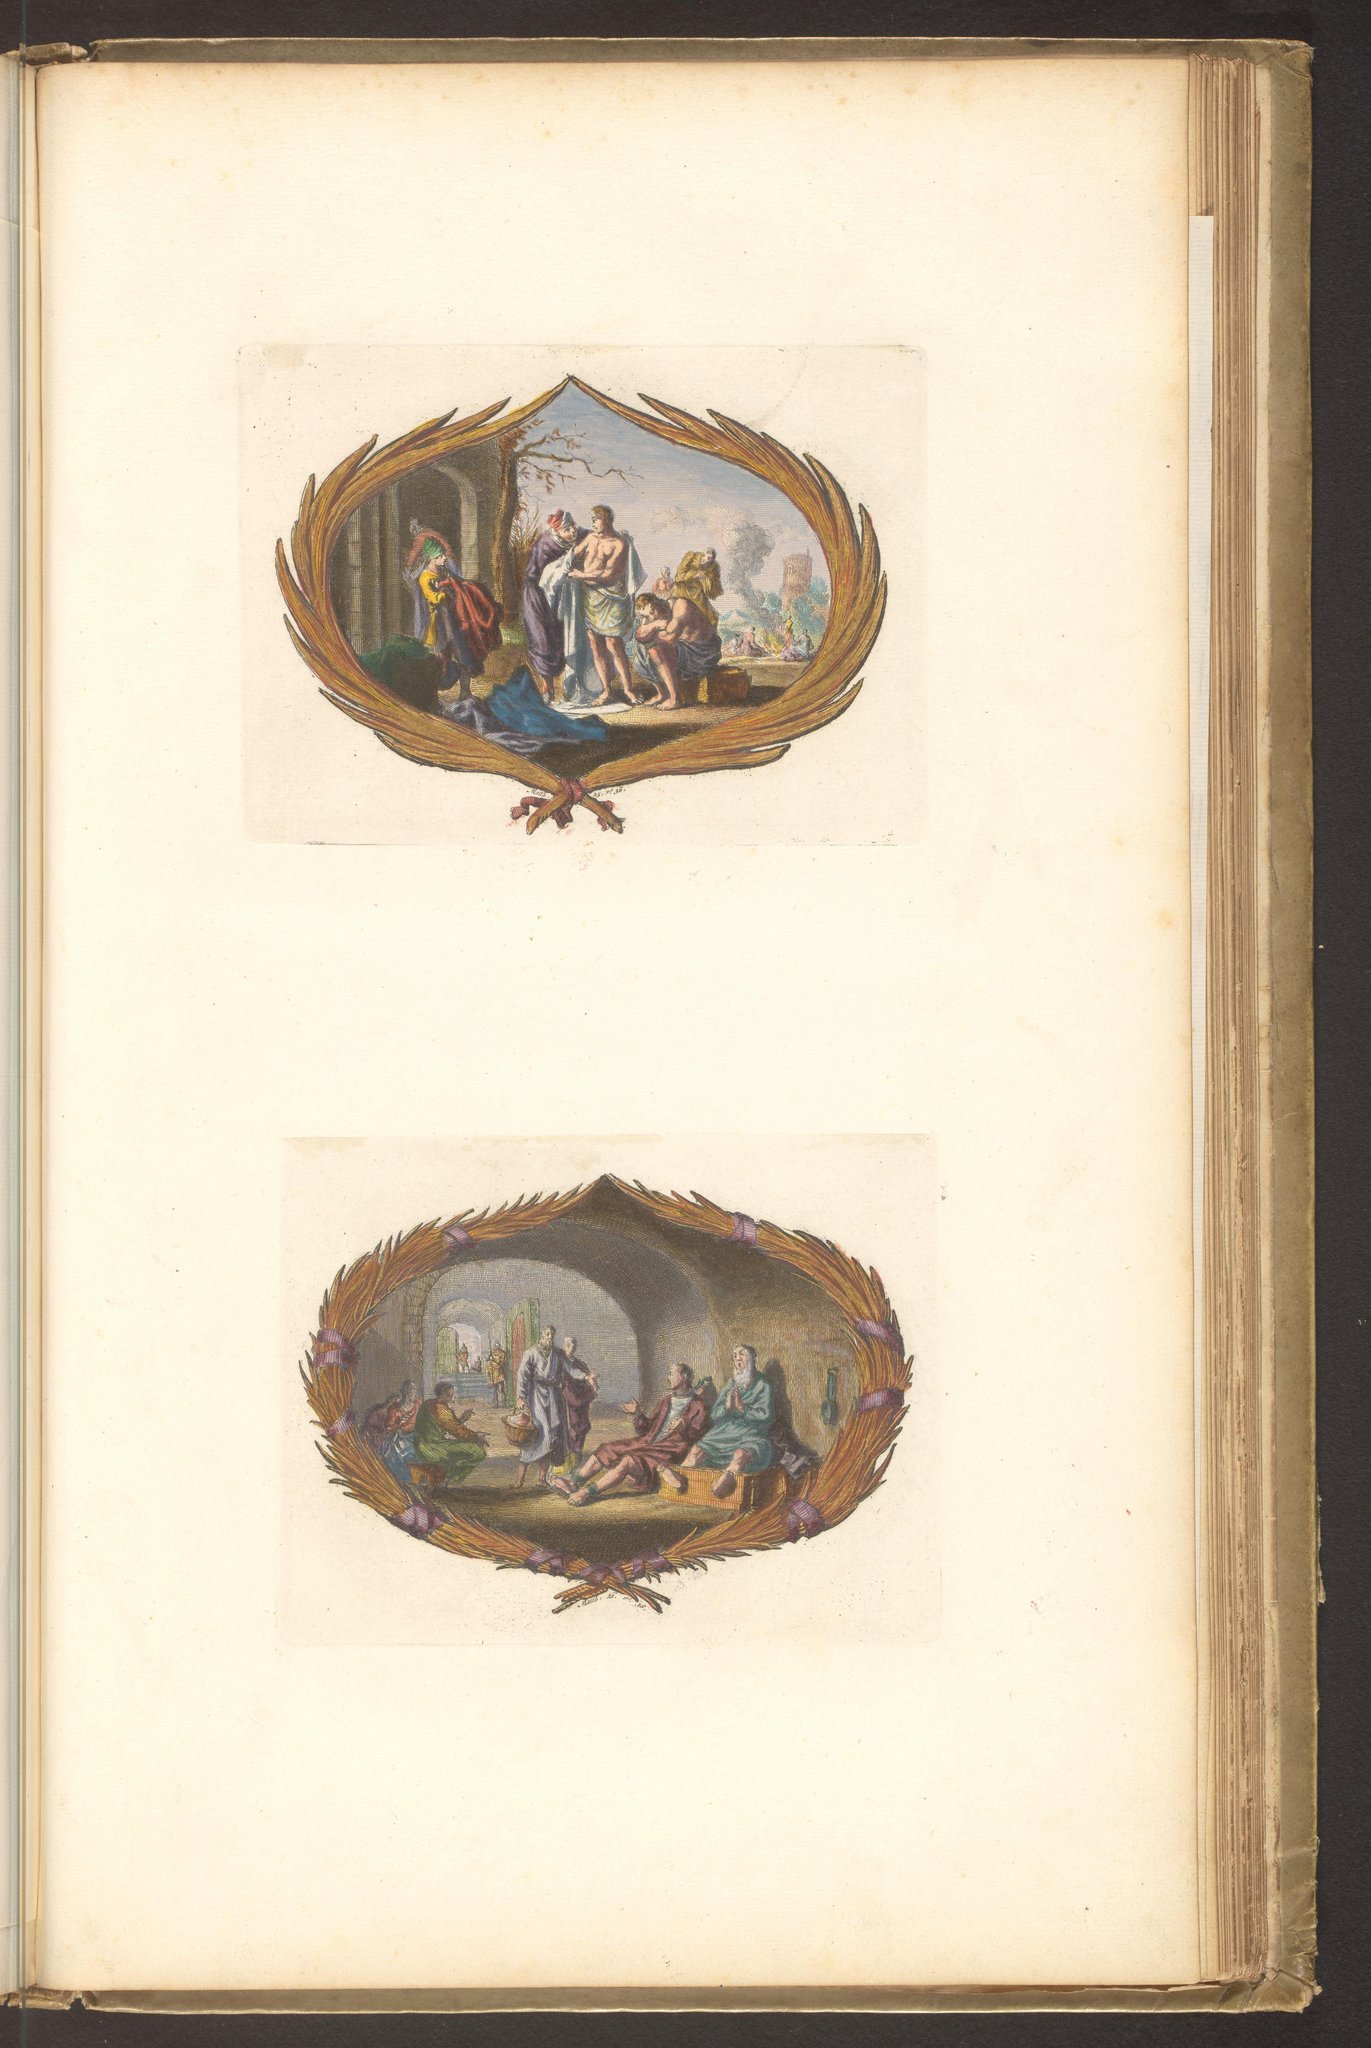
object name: print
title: Blad met twee vignetten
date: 1700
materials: paint, paper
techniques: etching, hand coloring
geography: amsterdam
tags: visiting or liberating the imprisoned, 'incarceratus solatur' ~ one of the (seven) acts of mercy, clothing the naked, 'nudus vestitur' ~ one of the (seven) acts of mercy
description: Blad met twee vignetten. Boven: de Naakten kleden. Onder: de Gevangenen bezoeken. Blad in het tweede deel van de prentbijbel met het Nieuwe Testament, uitgegeven door Pieter Mortier, Amsterdam 1700.